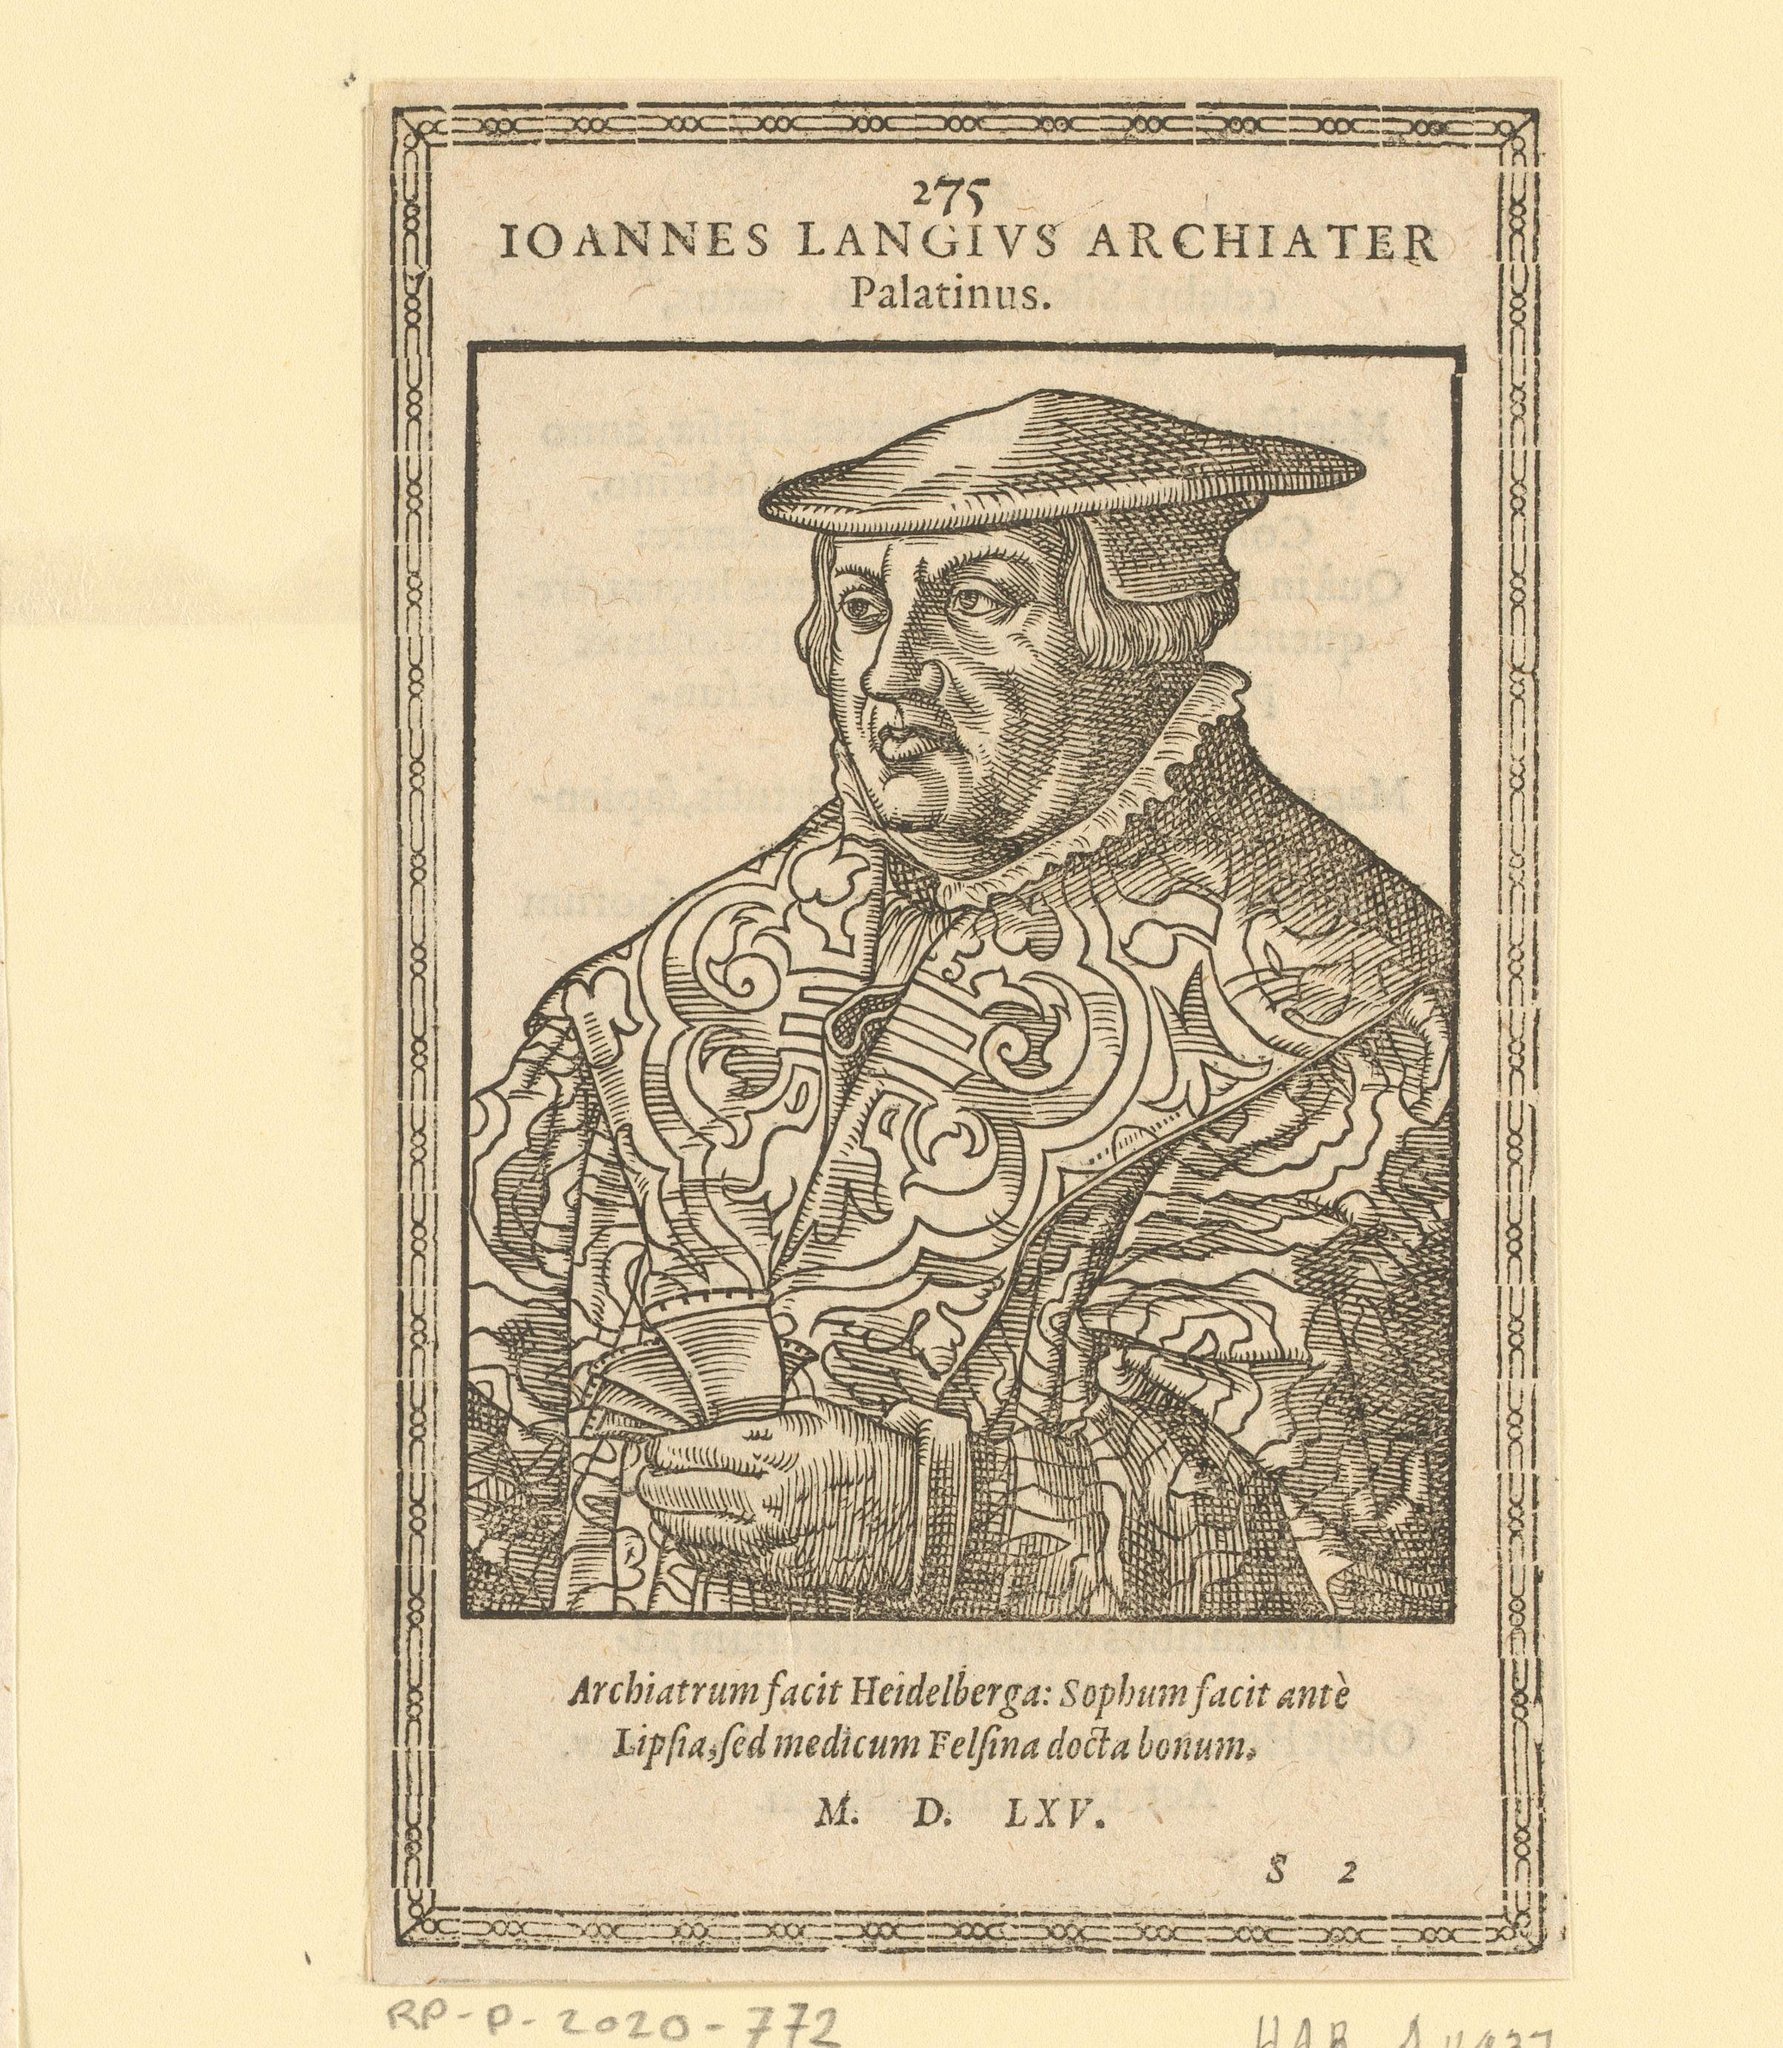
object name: book illustration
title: Portret van Johannes Lange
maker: bernhard jobin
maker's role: printer, publisher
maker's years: 1545-1593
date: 1590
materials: paper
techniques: letterpress printing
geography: straatsburg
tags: historical persons, physician, doctor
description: Prent uit: Reusner, Nikolaus. Icones sive imagines virorum literis illustrium (...). Straatsburg: Bernhard Jobin, 1590, p. 275. Prent voor het eerst verschenen in de eerste editie van 1587. Prent ook gebruikt in latere publicaties.